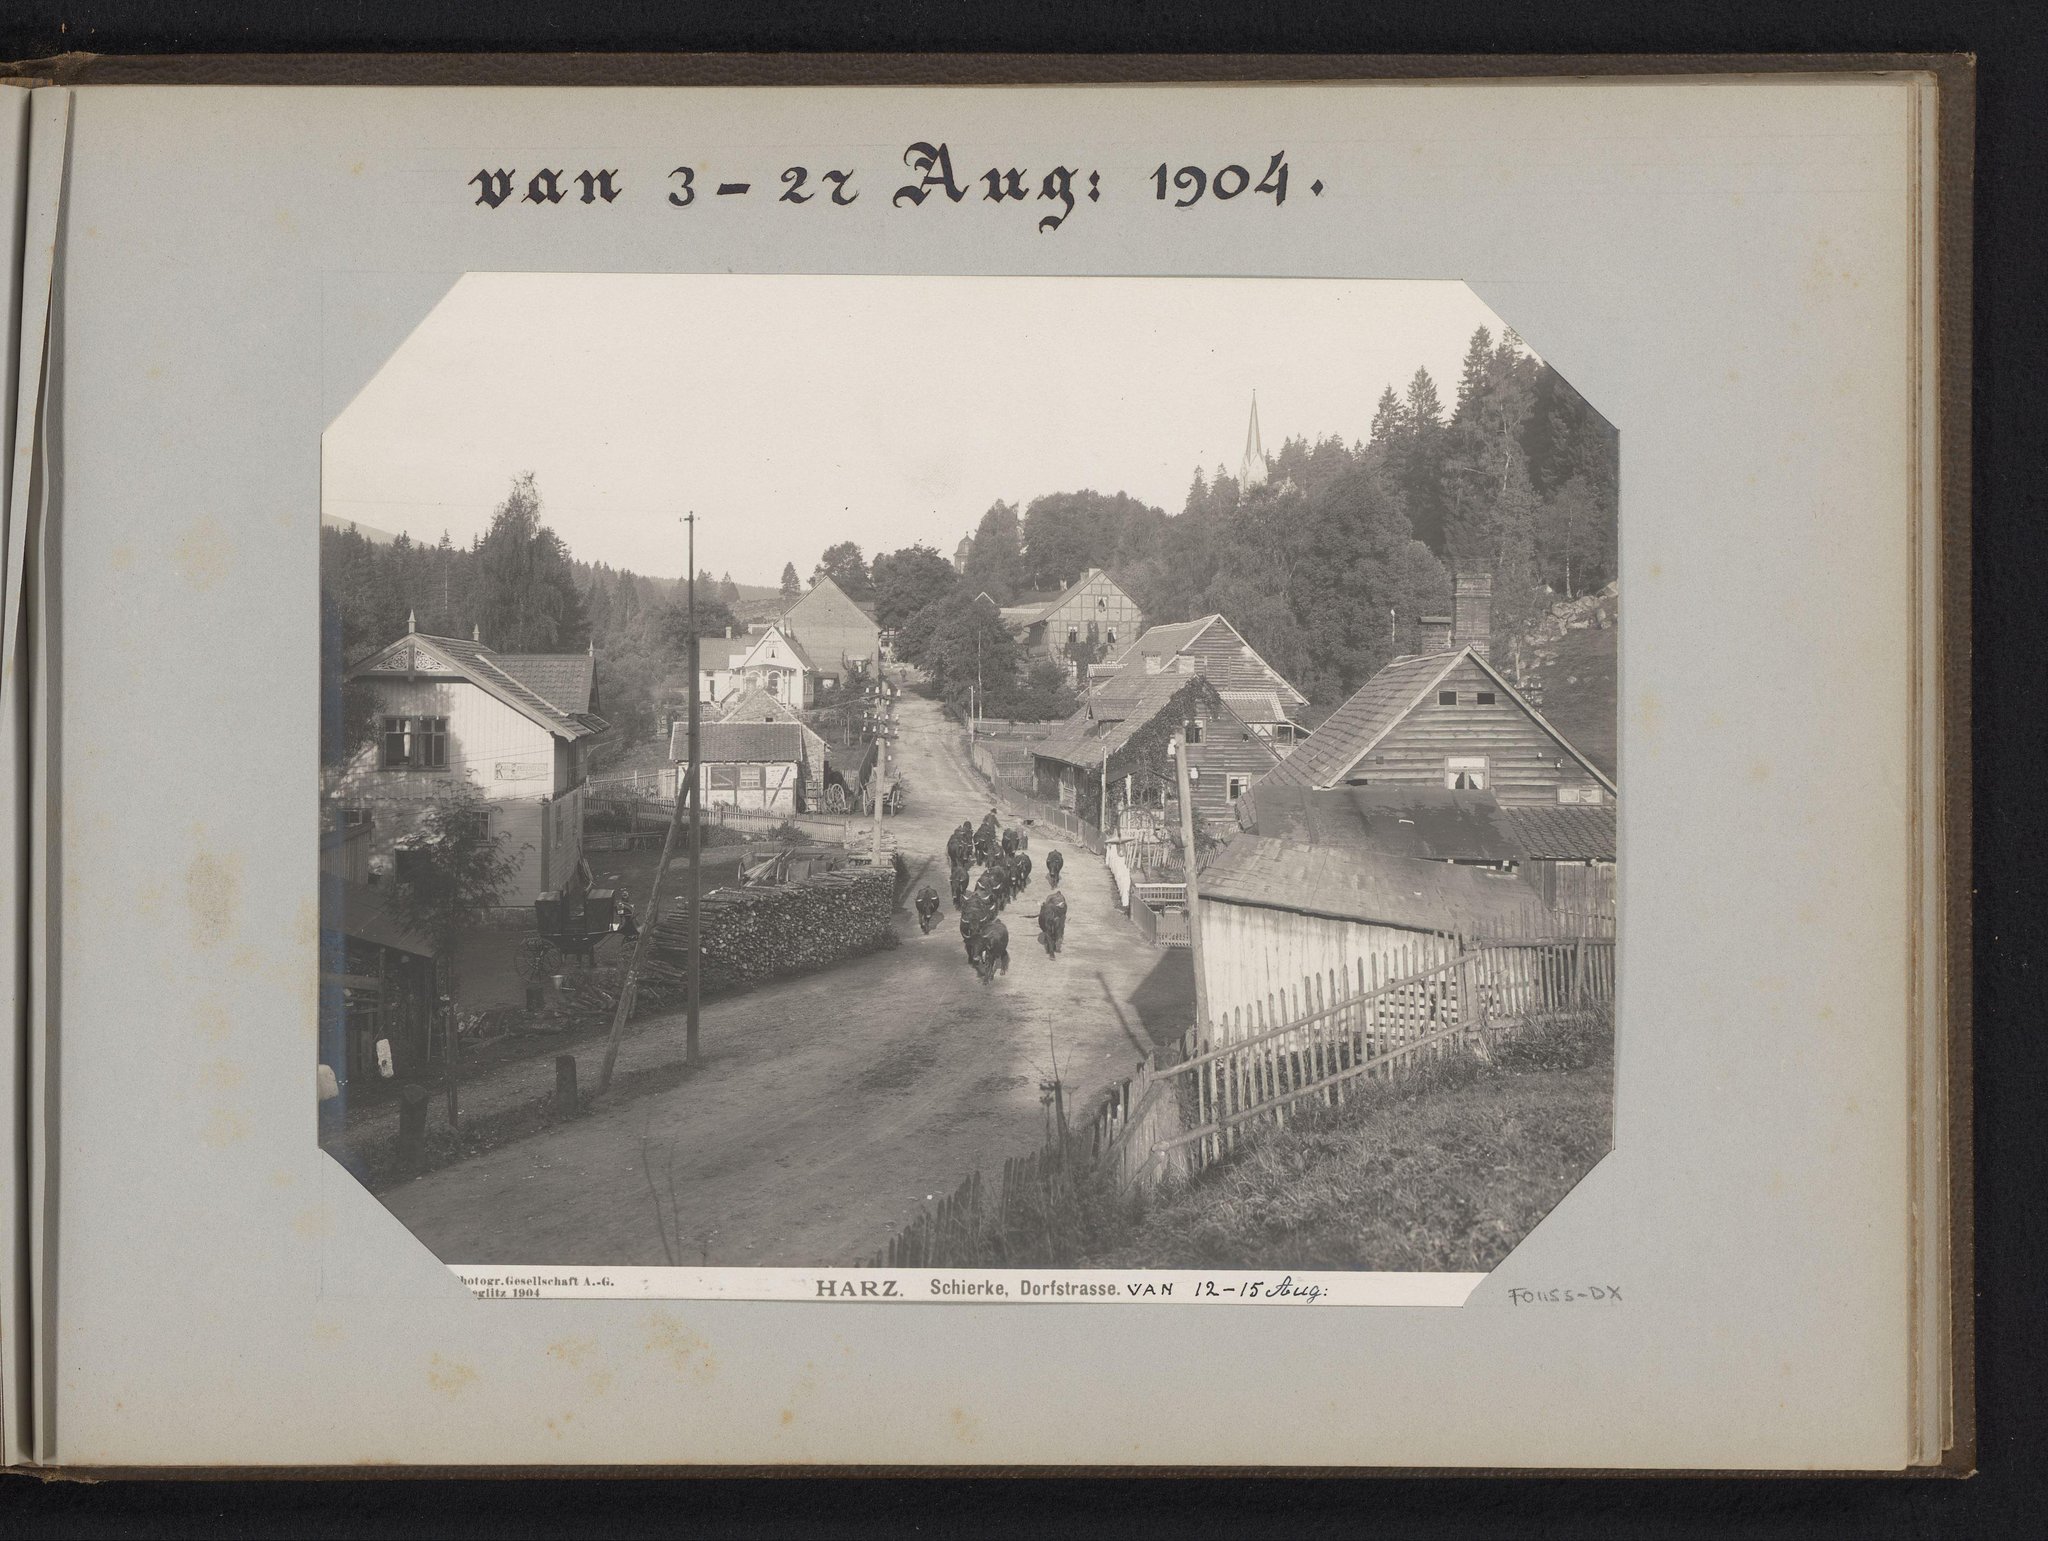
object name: album leaf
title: Gezicht op de dorpsstraat met vee te Schierke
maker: Anonymous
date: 1904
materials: photographic support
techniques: gelatin silver print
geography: berlin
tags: cattle driving, cattle driver, village street (+ city(-scape) with figures, staffage)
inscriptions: annotation: ‘[Reis door den Harz.] van 3 - 27 Aug: 1904’, inscription: ‘Verlag der Neuen Photogr. Gesellschaft A.-G./ Berlin-Steglitz 1904/ Harz. Schierke, Dorfstrasse./ 1626’, annotation: ‘van 12-15 Aug:’